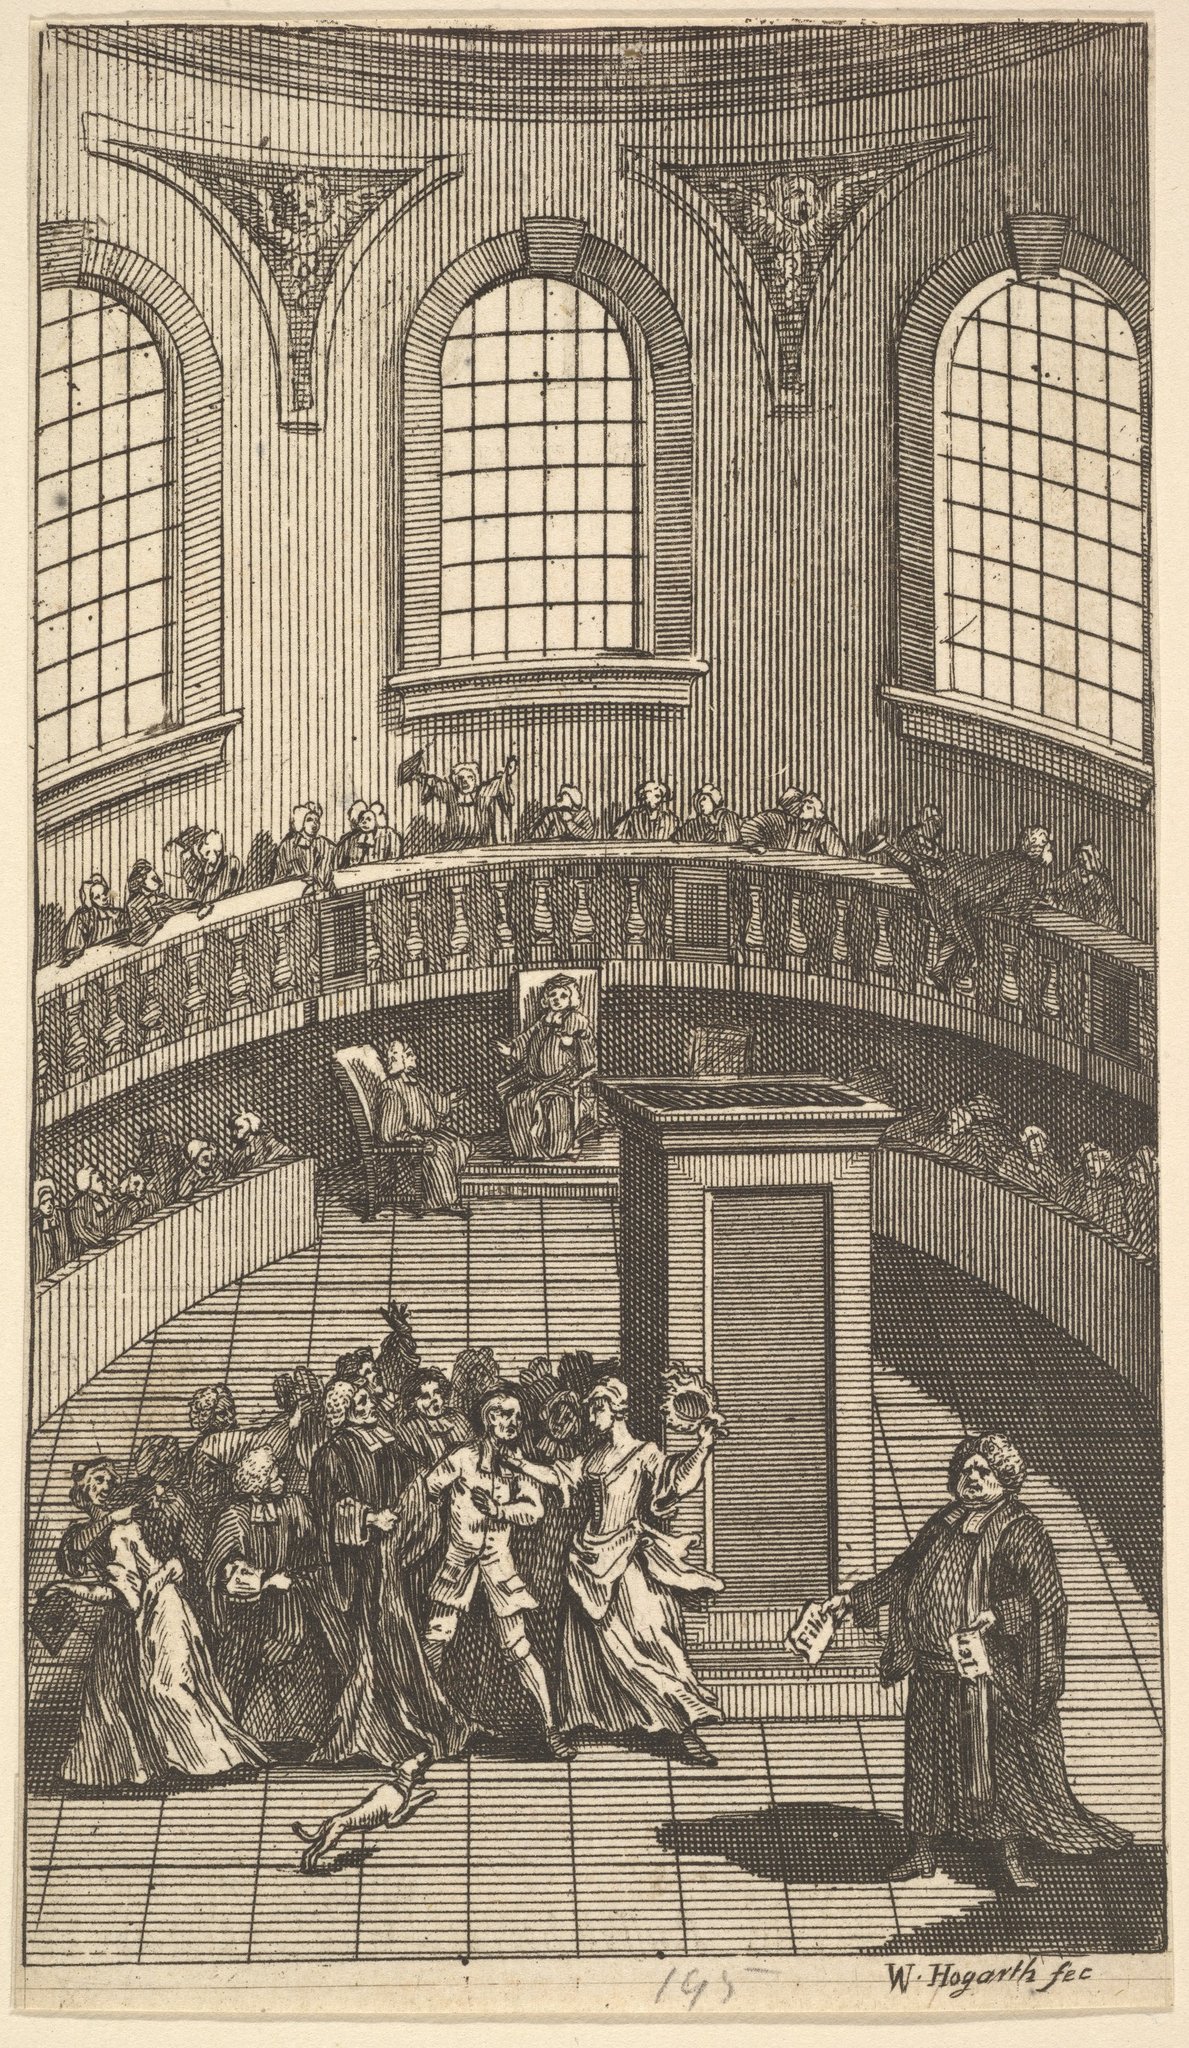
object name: print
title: Frontispiece to Nicholas Amhurst's "Terrae-Filius"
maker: william hogarth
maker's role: artist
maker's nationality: british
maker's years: 1697-1764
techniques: engraving, etching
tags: satire,men,women,dogs